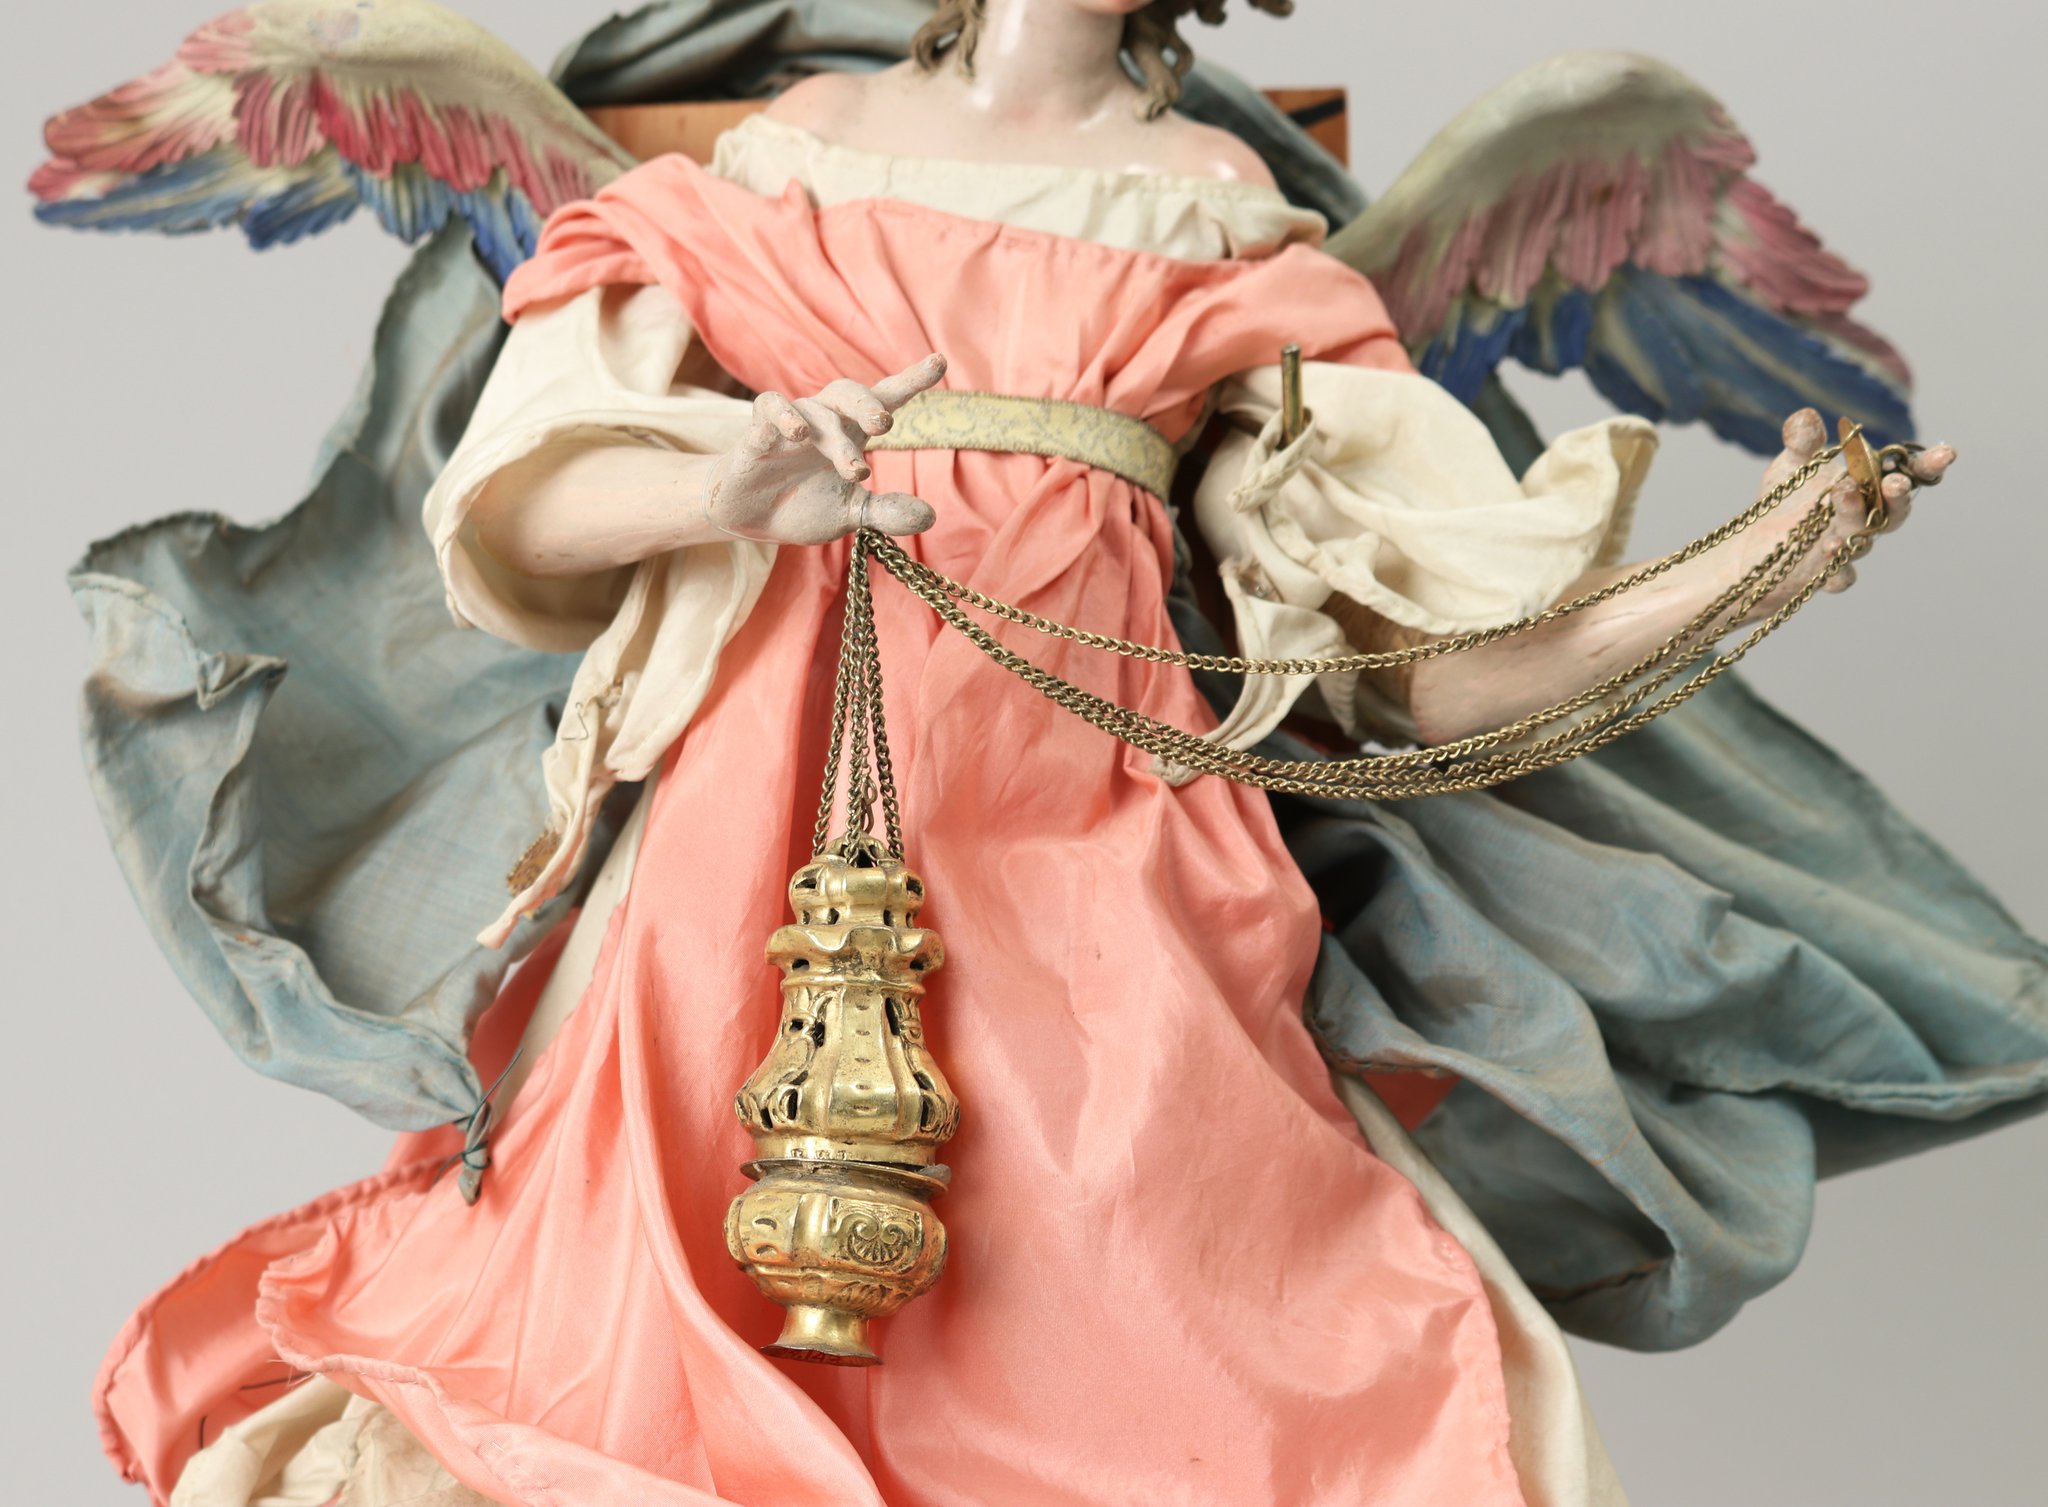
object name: crèche figure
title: Censer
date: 1751-1800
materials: silver gilt